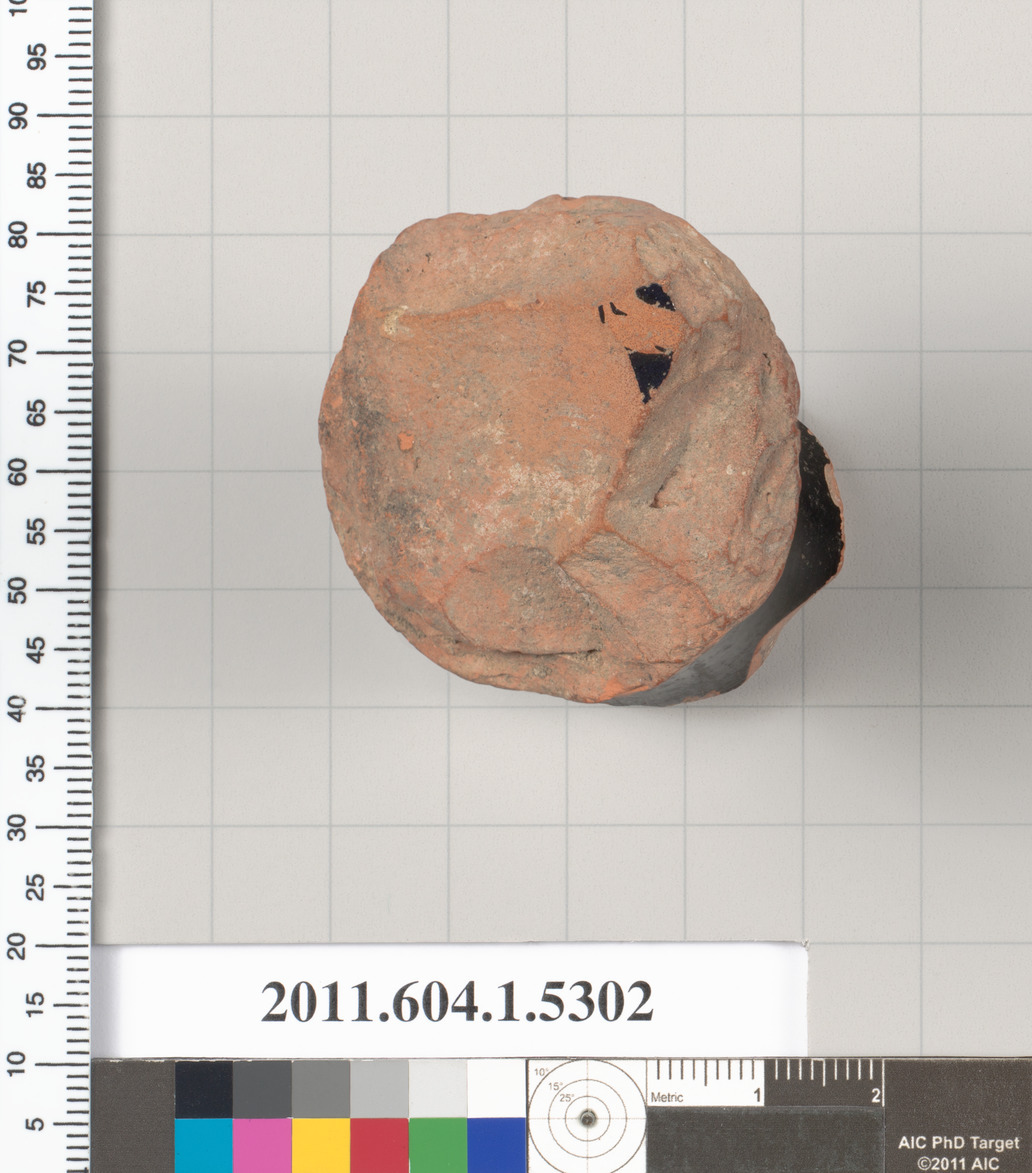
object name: kylix fragment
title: Terracotta fragment of a kylix (drinking cup)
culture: greek, attic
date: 500-480 BCE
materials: terracotta